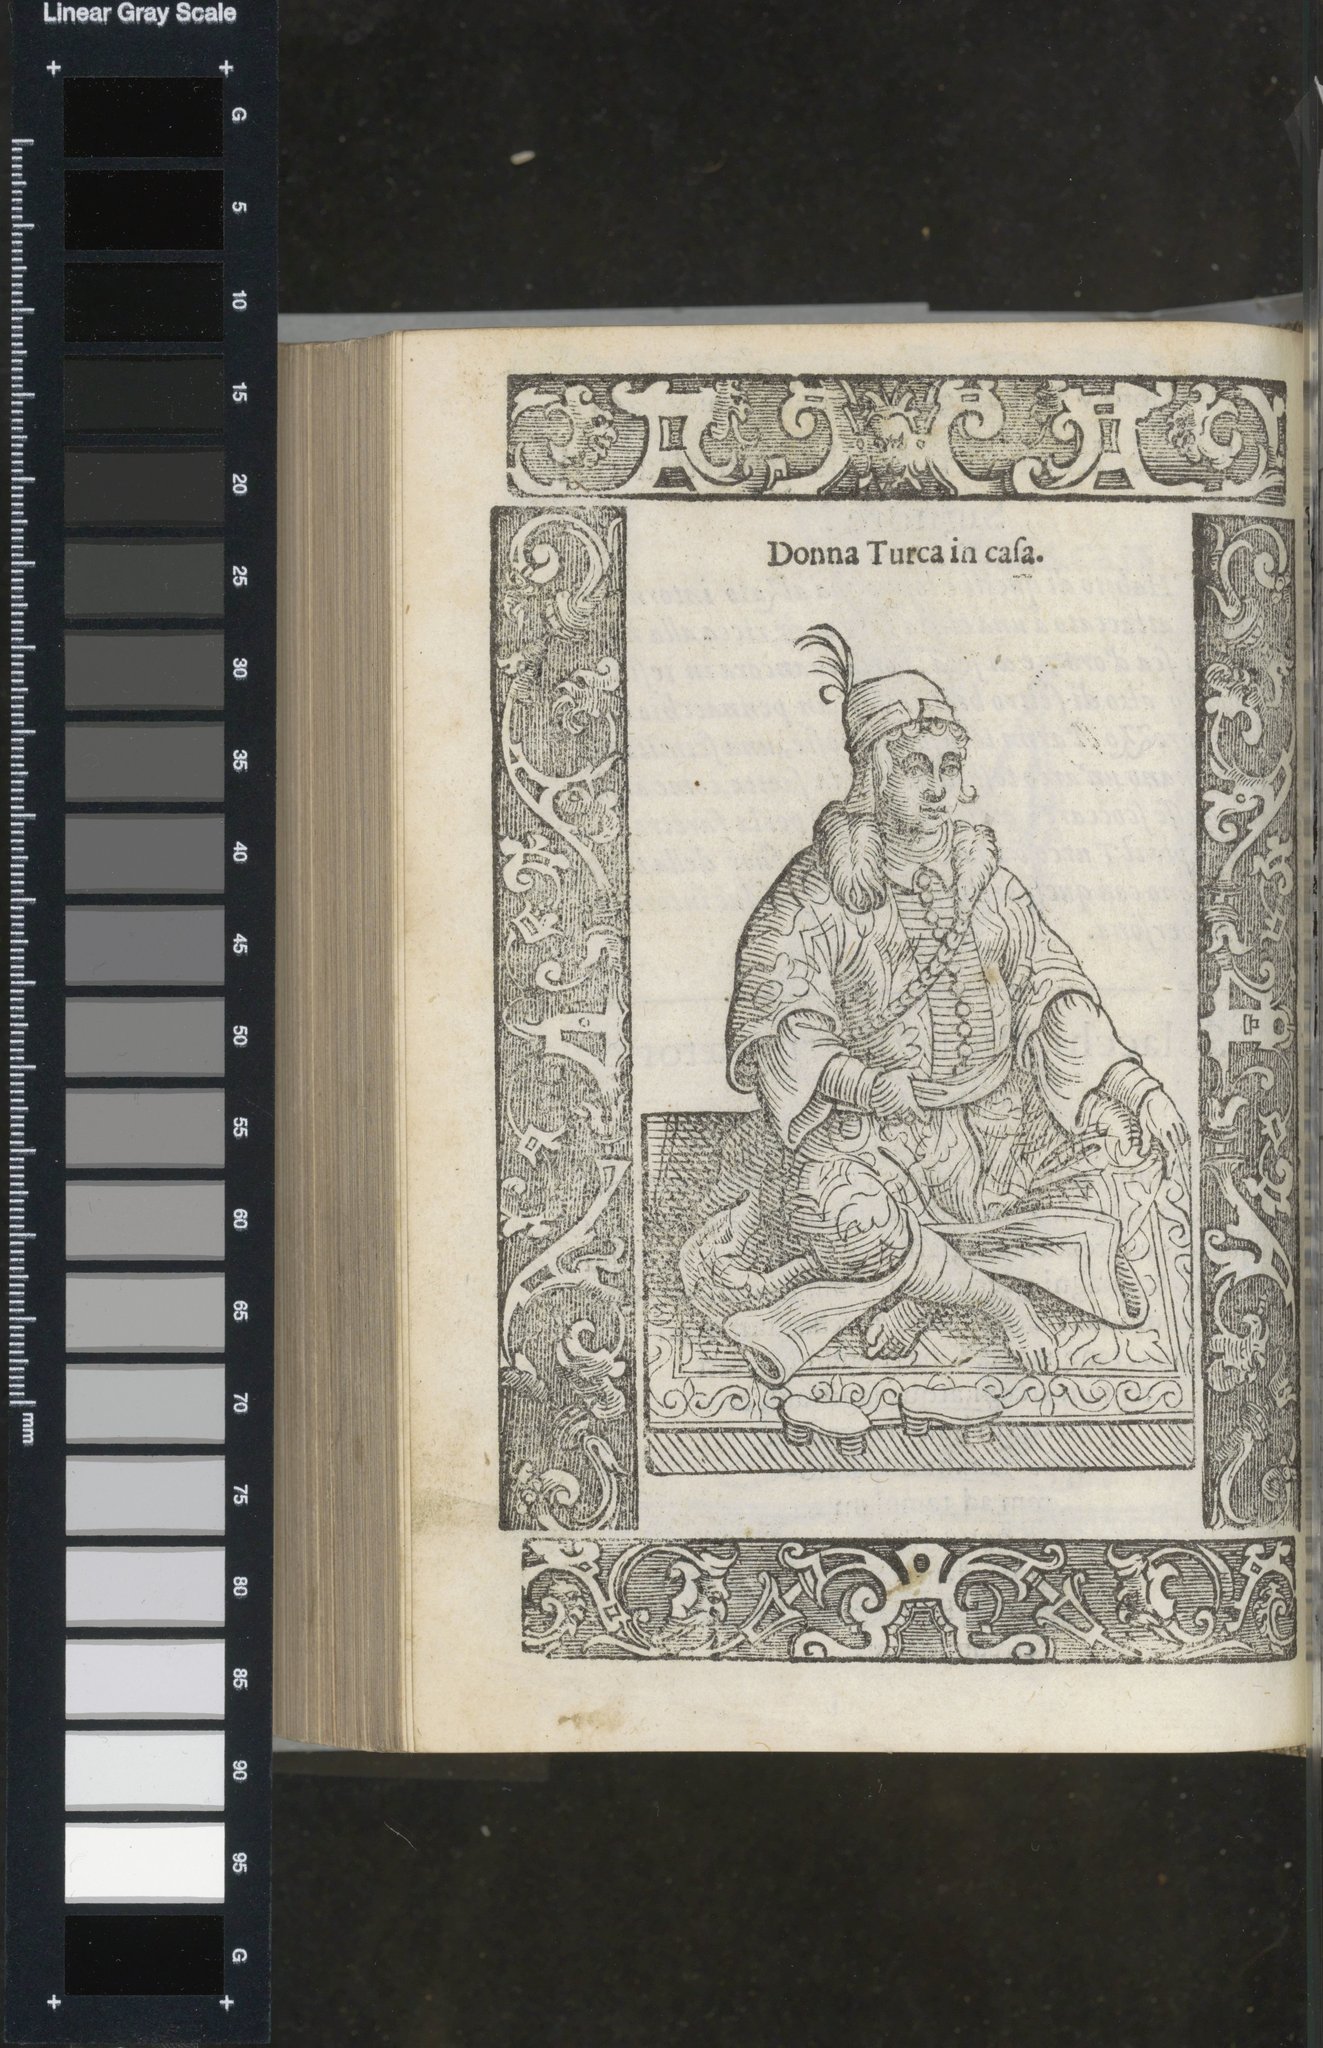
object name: costume print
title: Donna Turca in casa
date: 1598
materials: paper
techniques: woodcut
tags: fashion plates